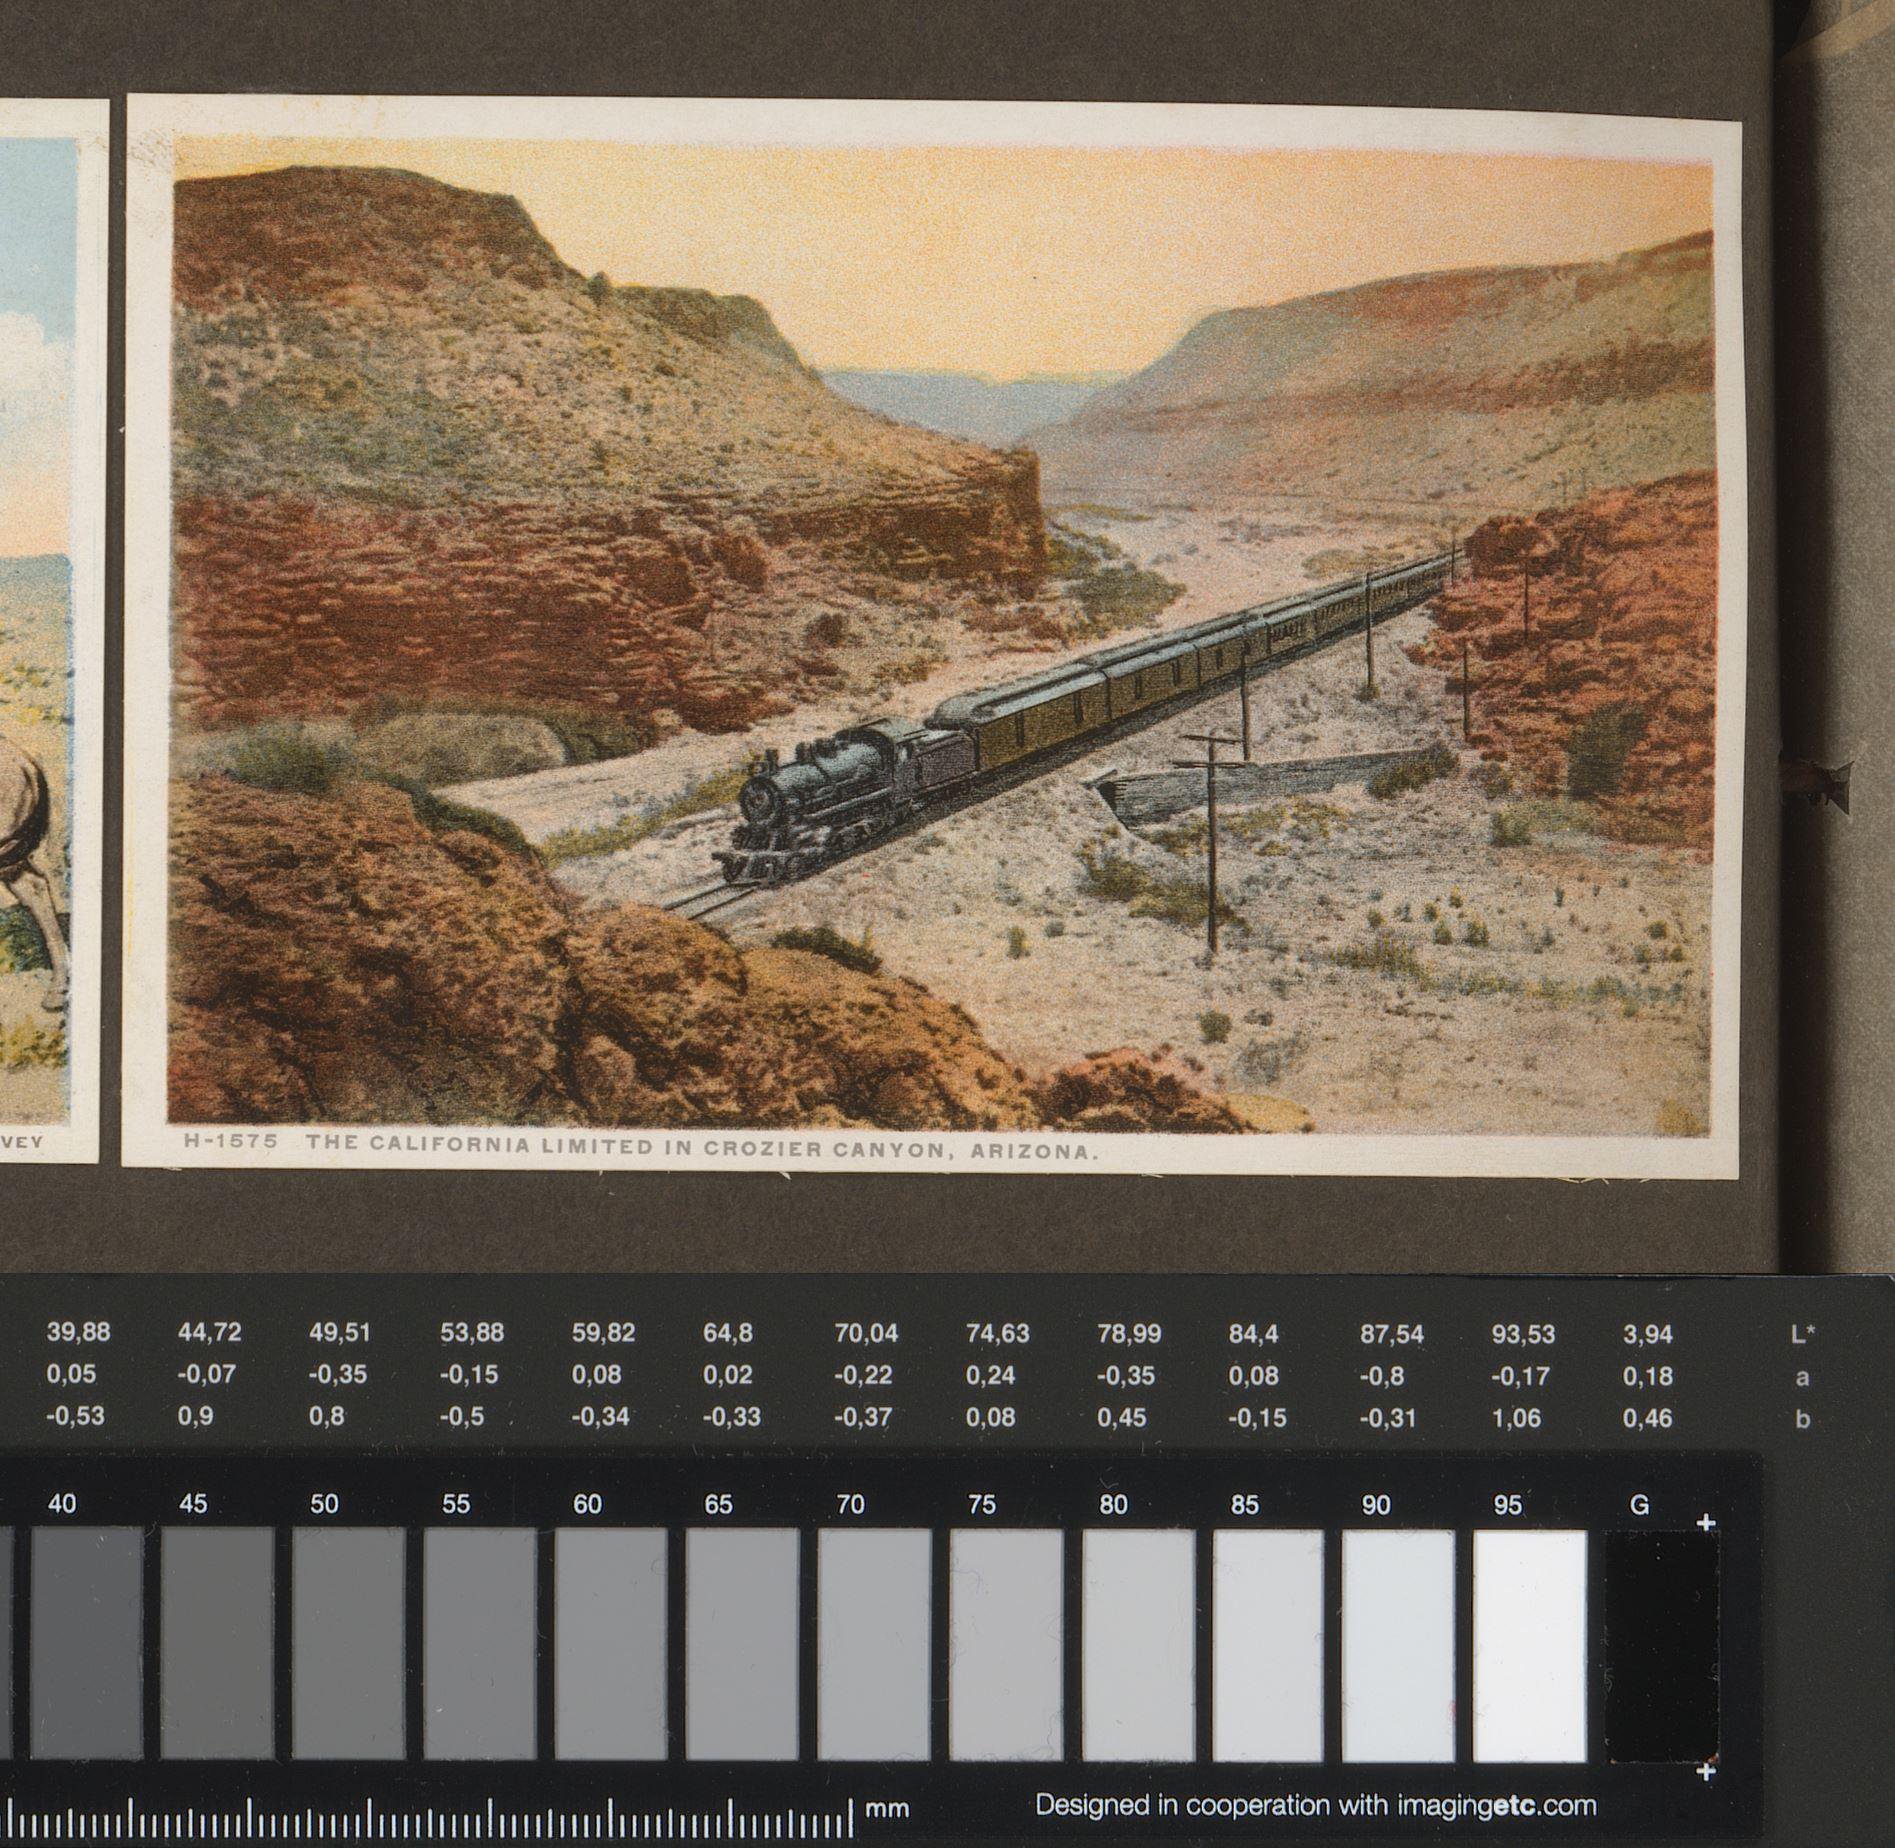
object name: ansichtkaart, prentbriefkaart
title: The California Limited in Crozier Canyon, Arizona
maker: Anonymous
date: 1928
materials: paper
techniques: lithograph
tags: ravine, chasm, abyss, canyon, railway, train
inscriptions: number: ‘H-1575’